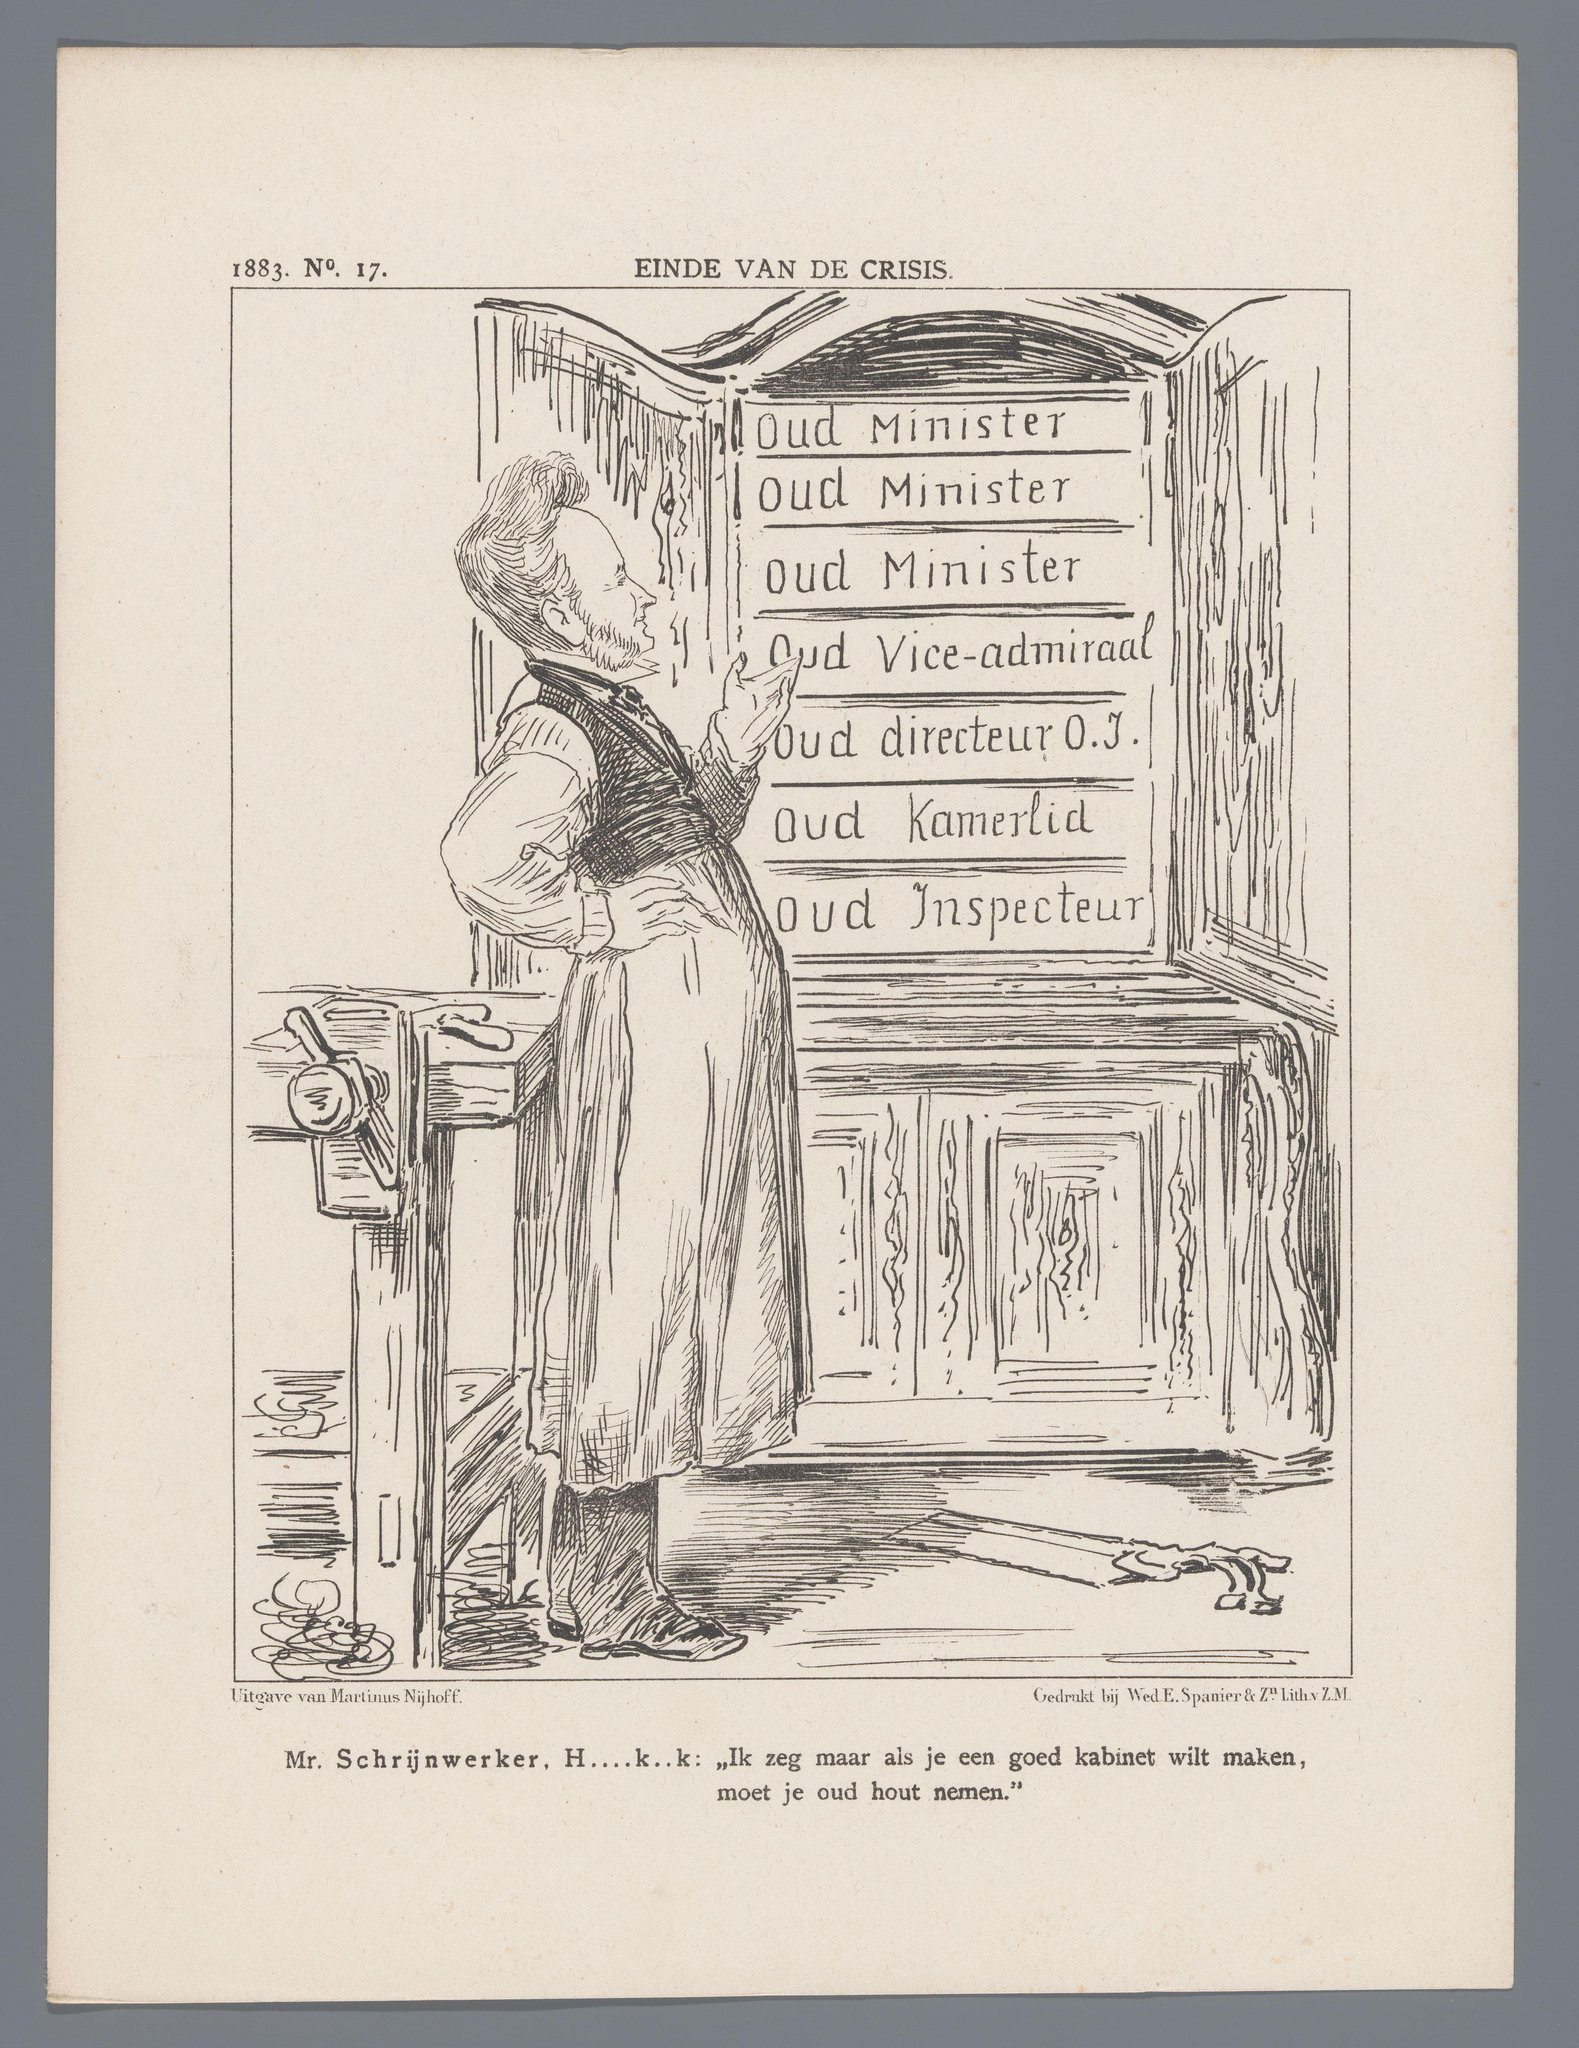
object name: cartoon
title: Einde van de crisis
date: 1883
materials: paper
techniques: lithograph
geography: netherlands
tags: tweede kamerlid, minister van binnenlandse zaken, minister van justitie, jan heemskerk azn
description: Spotprent op de politieke crisis, 1883. Heemskerk als schrijnwerker maakt een nieuw kabinet. Plaat verschenen bij het weekblad De Nederlandsche Spectator, nr. 17, 1883.